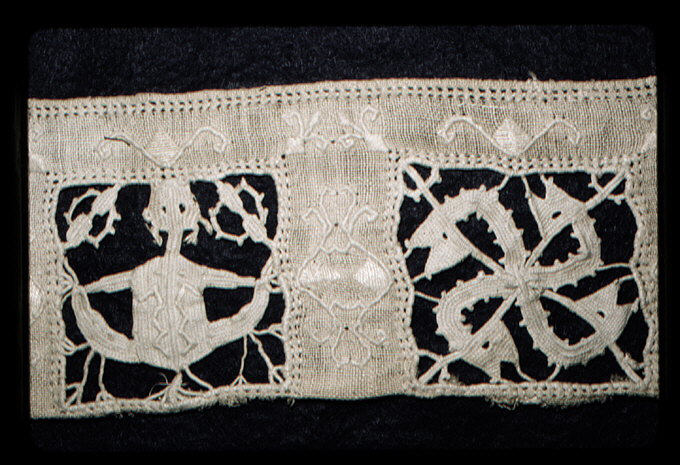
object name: band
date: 1600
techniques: embroidery